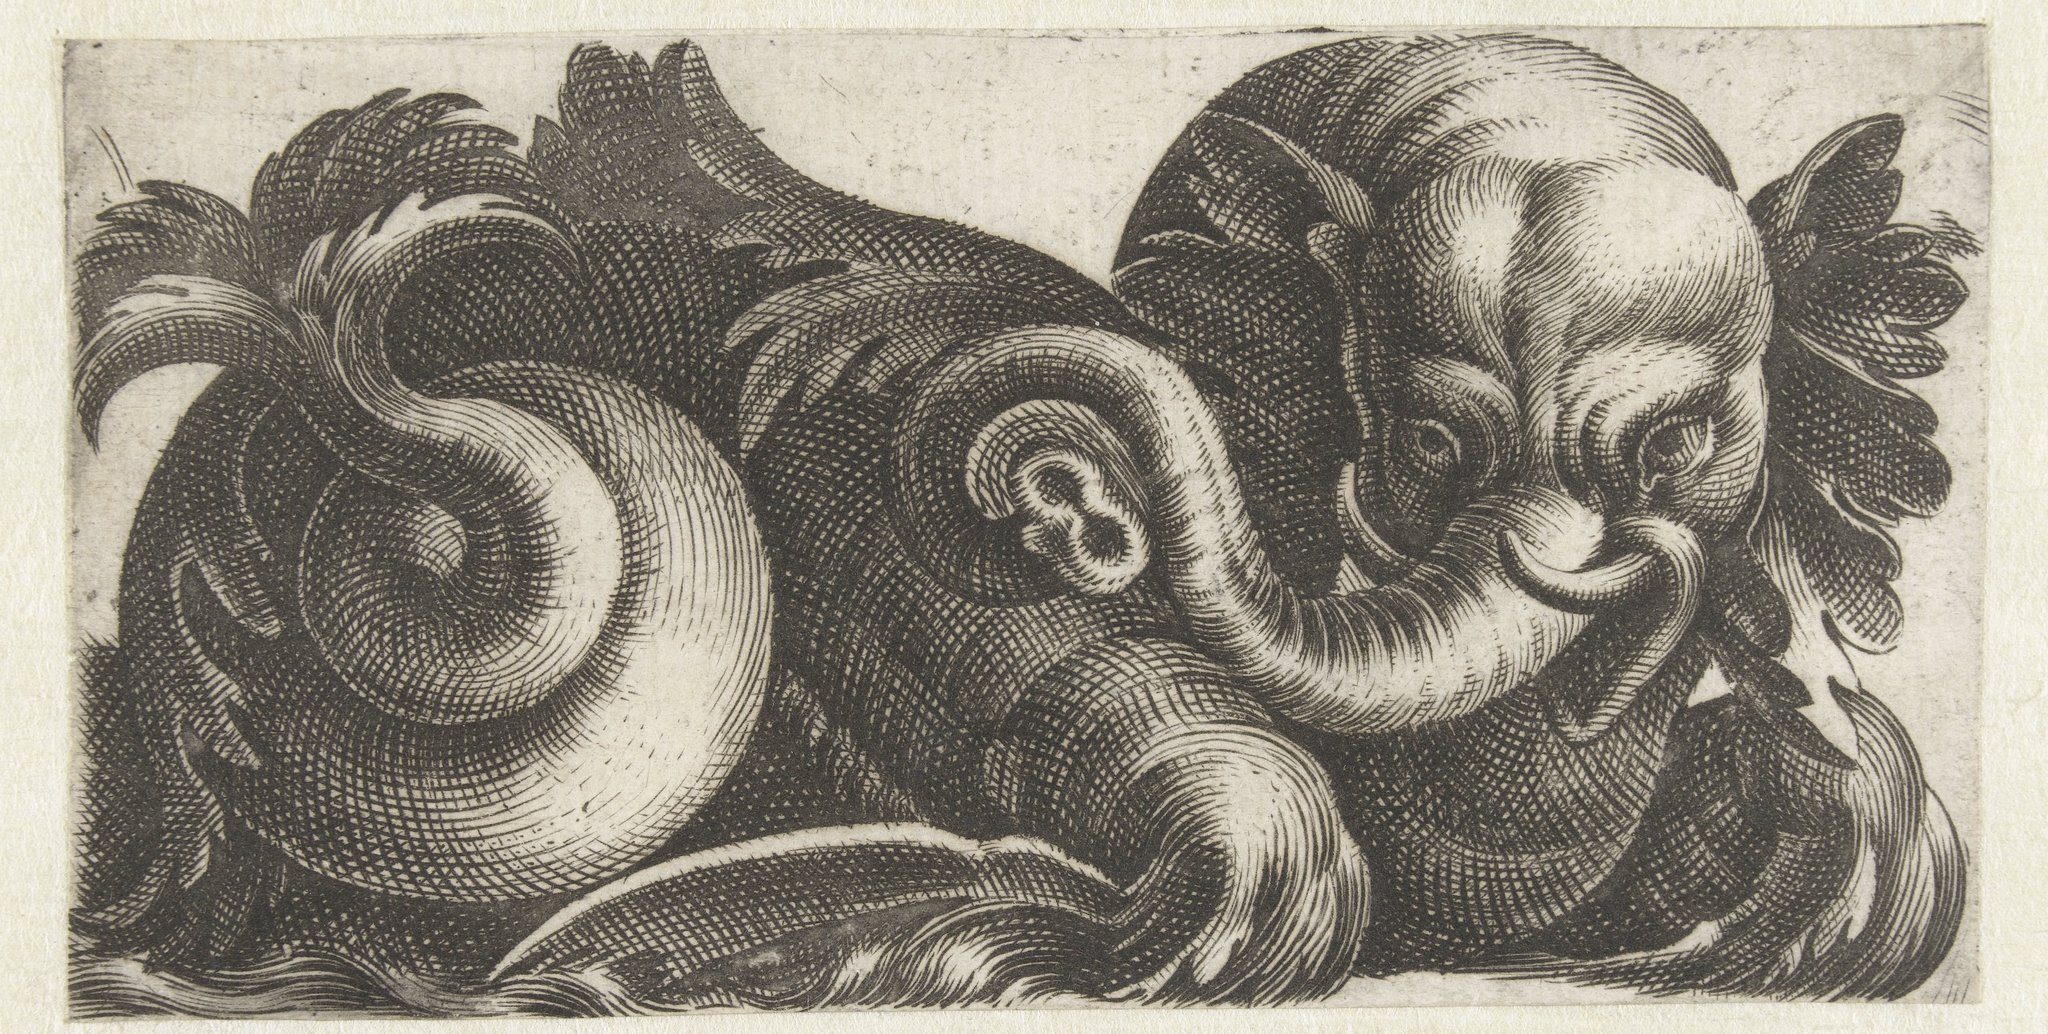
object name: ornament print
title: Zee-olifant met oren van bladeren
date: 1580-1610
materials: paper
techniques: engraving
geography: rome